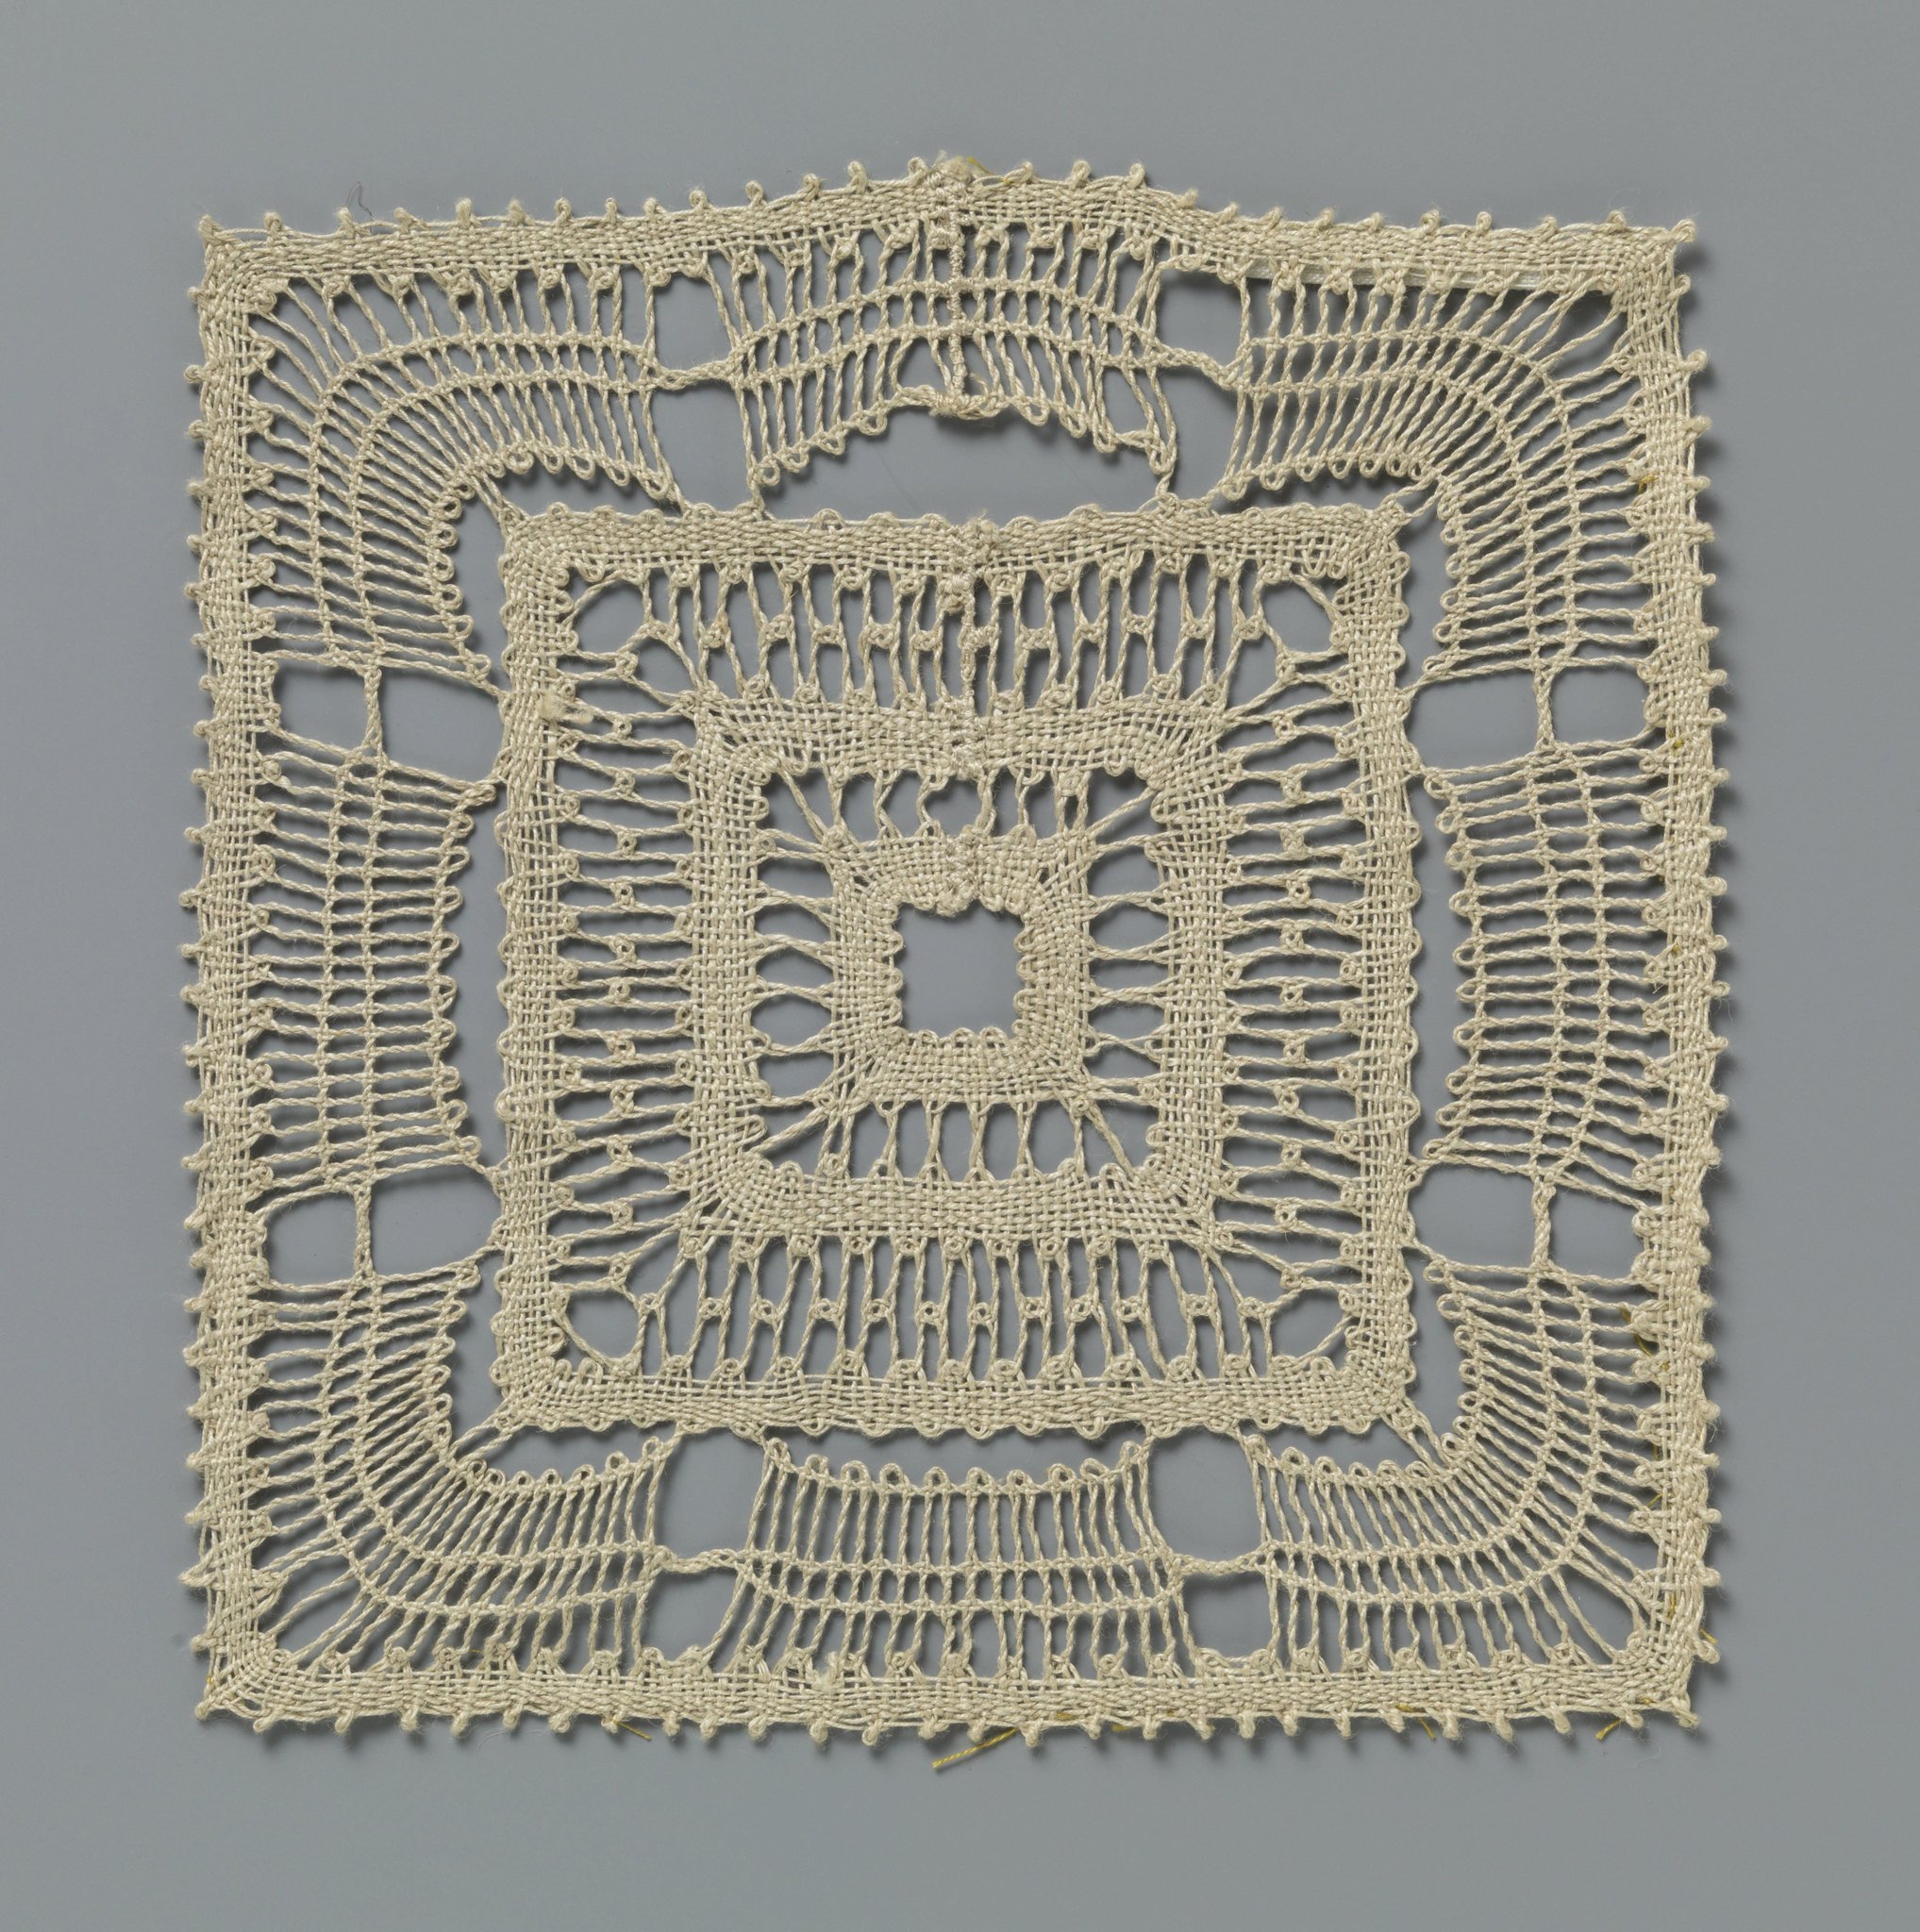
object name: mat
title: Kleedje van kloskant met vierkanten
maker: Anonymous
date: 1925-1934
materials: linen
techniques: lace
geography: volvic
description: Kleedje van naturelkleurige kloskant. Vierkant model. Het patroon bestaat uit een opengewerkt vierkantje in het centrum van het kleedje, waar de omtrekken van drie steeds groter wordende vierkanten omheen liggen. De omtrekken worden gevormd door een bandje in linnenslag. Het grootste vierkant wordt gevormd door een bandje in linnenslag dat langs de buitenkant van het kleedje loopt. De ruimte tussen de omtrekken wordt naar buiten toe gevuld door steeds bredere banen met onder andere overstekende paren die een open netwerk vormen en vetergatslagen.